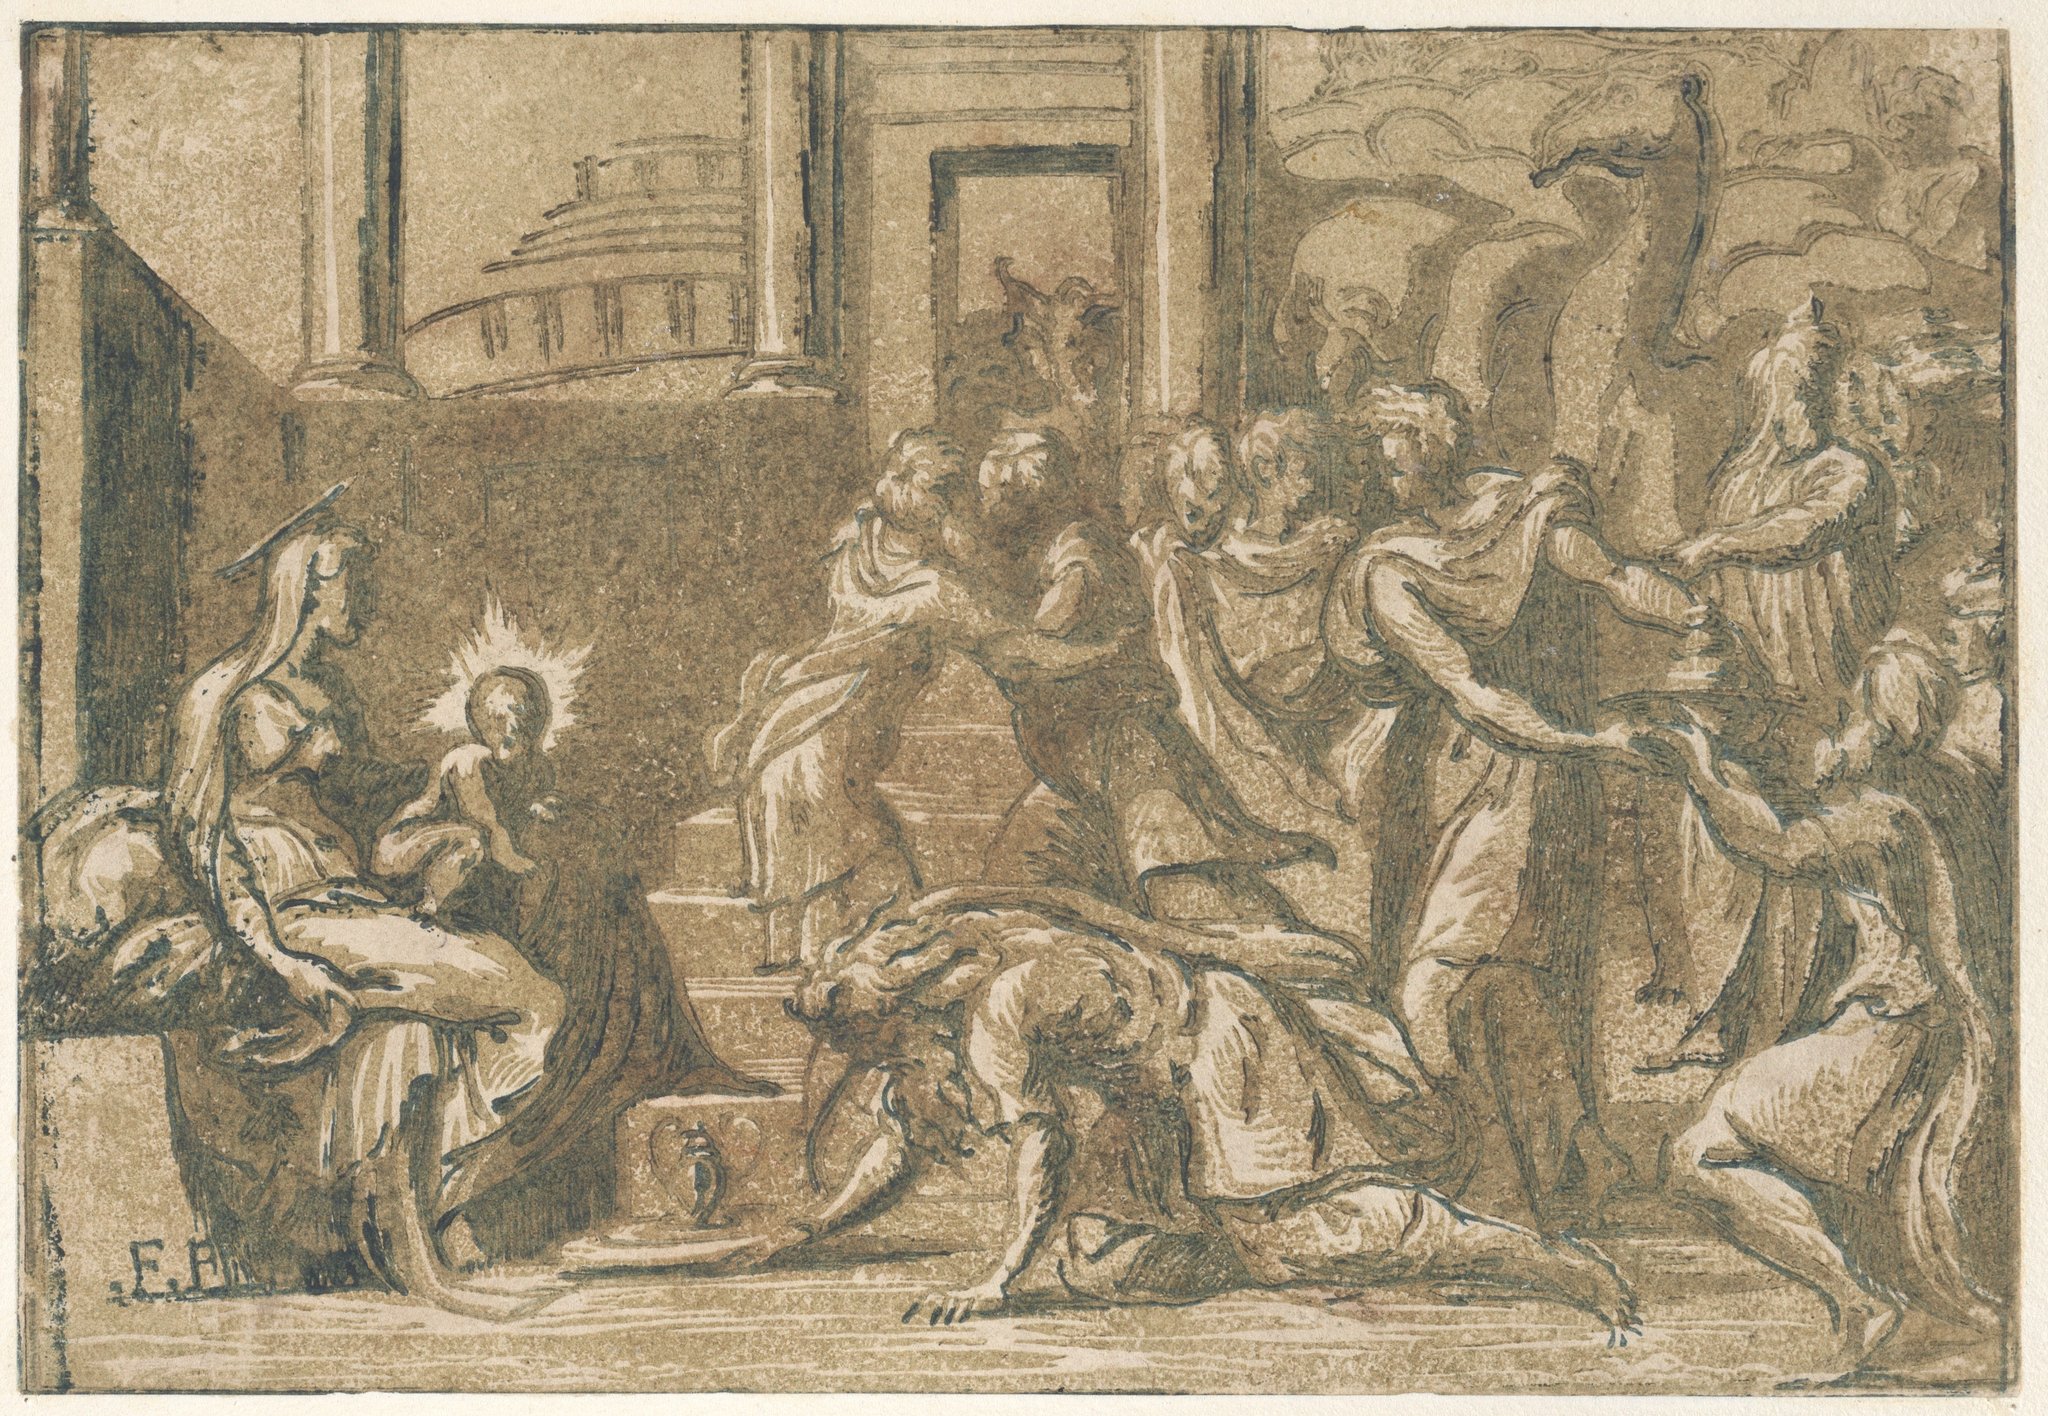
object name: print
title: The Adoration of the Magi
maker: niccolò vicentino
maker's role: artist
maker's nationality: italian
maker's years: 1510-1550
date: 1540-1550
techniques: woodcut